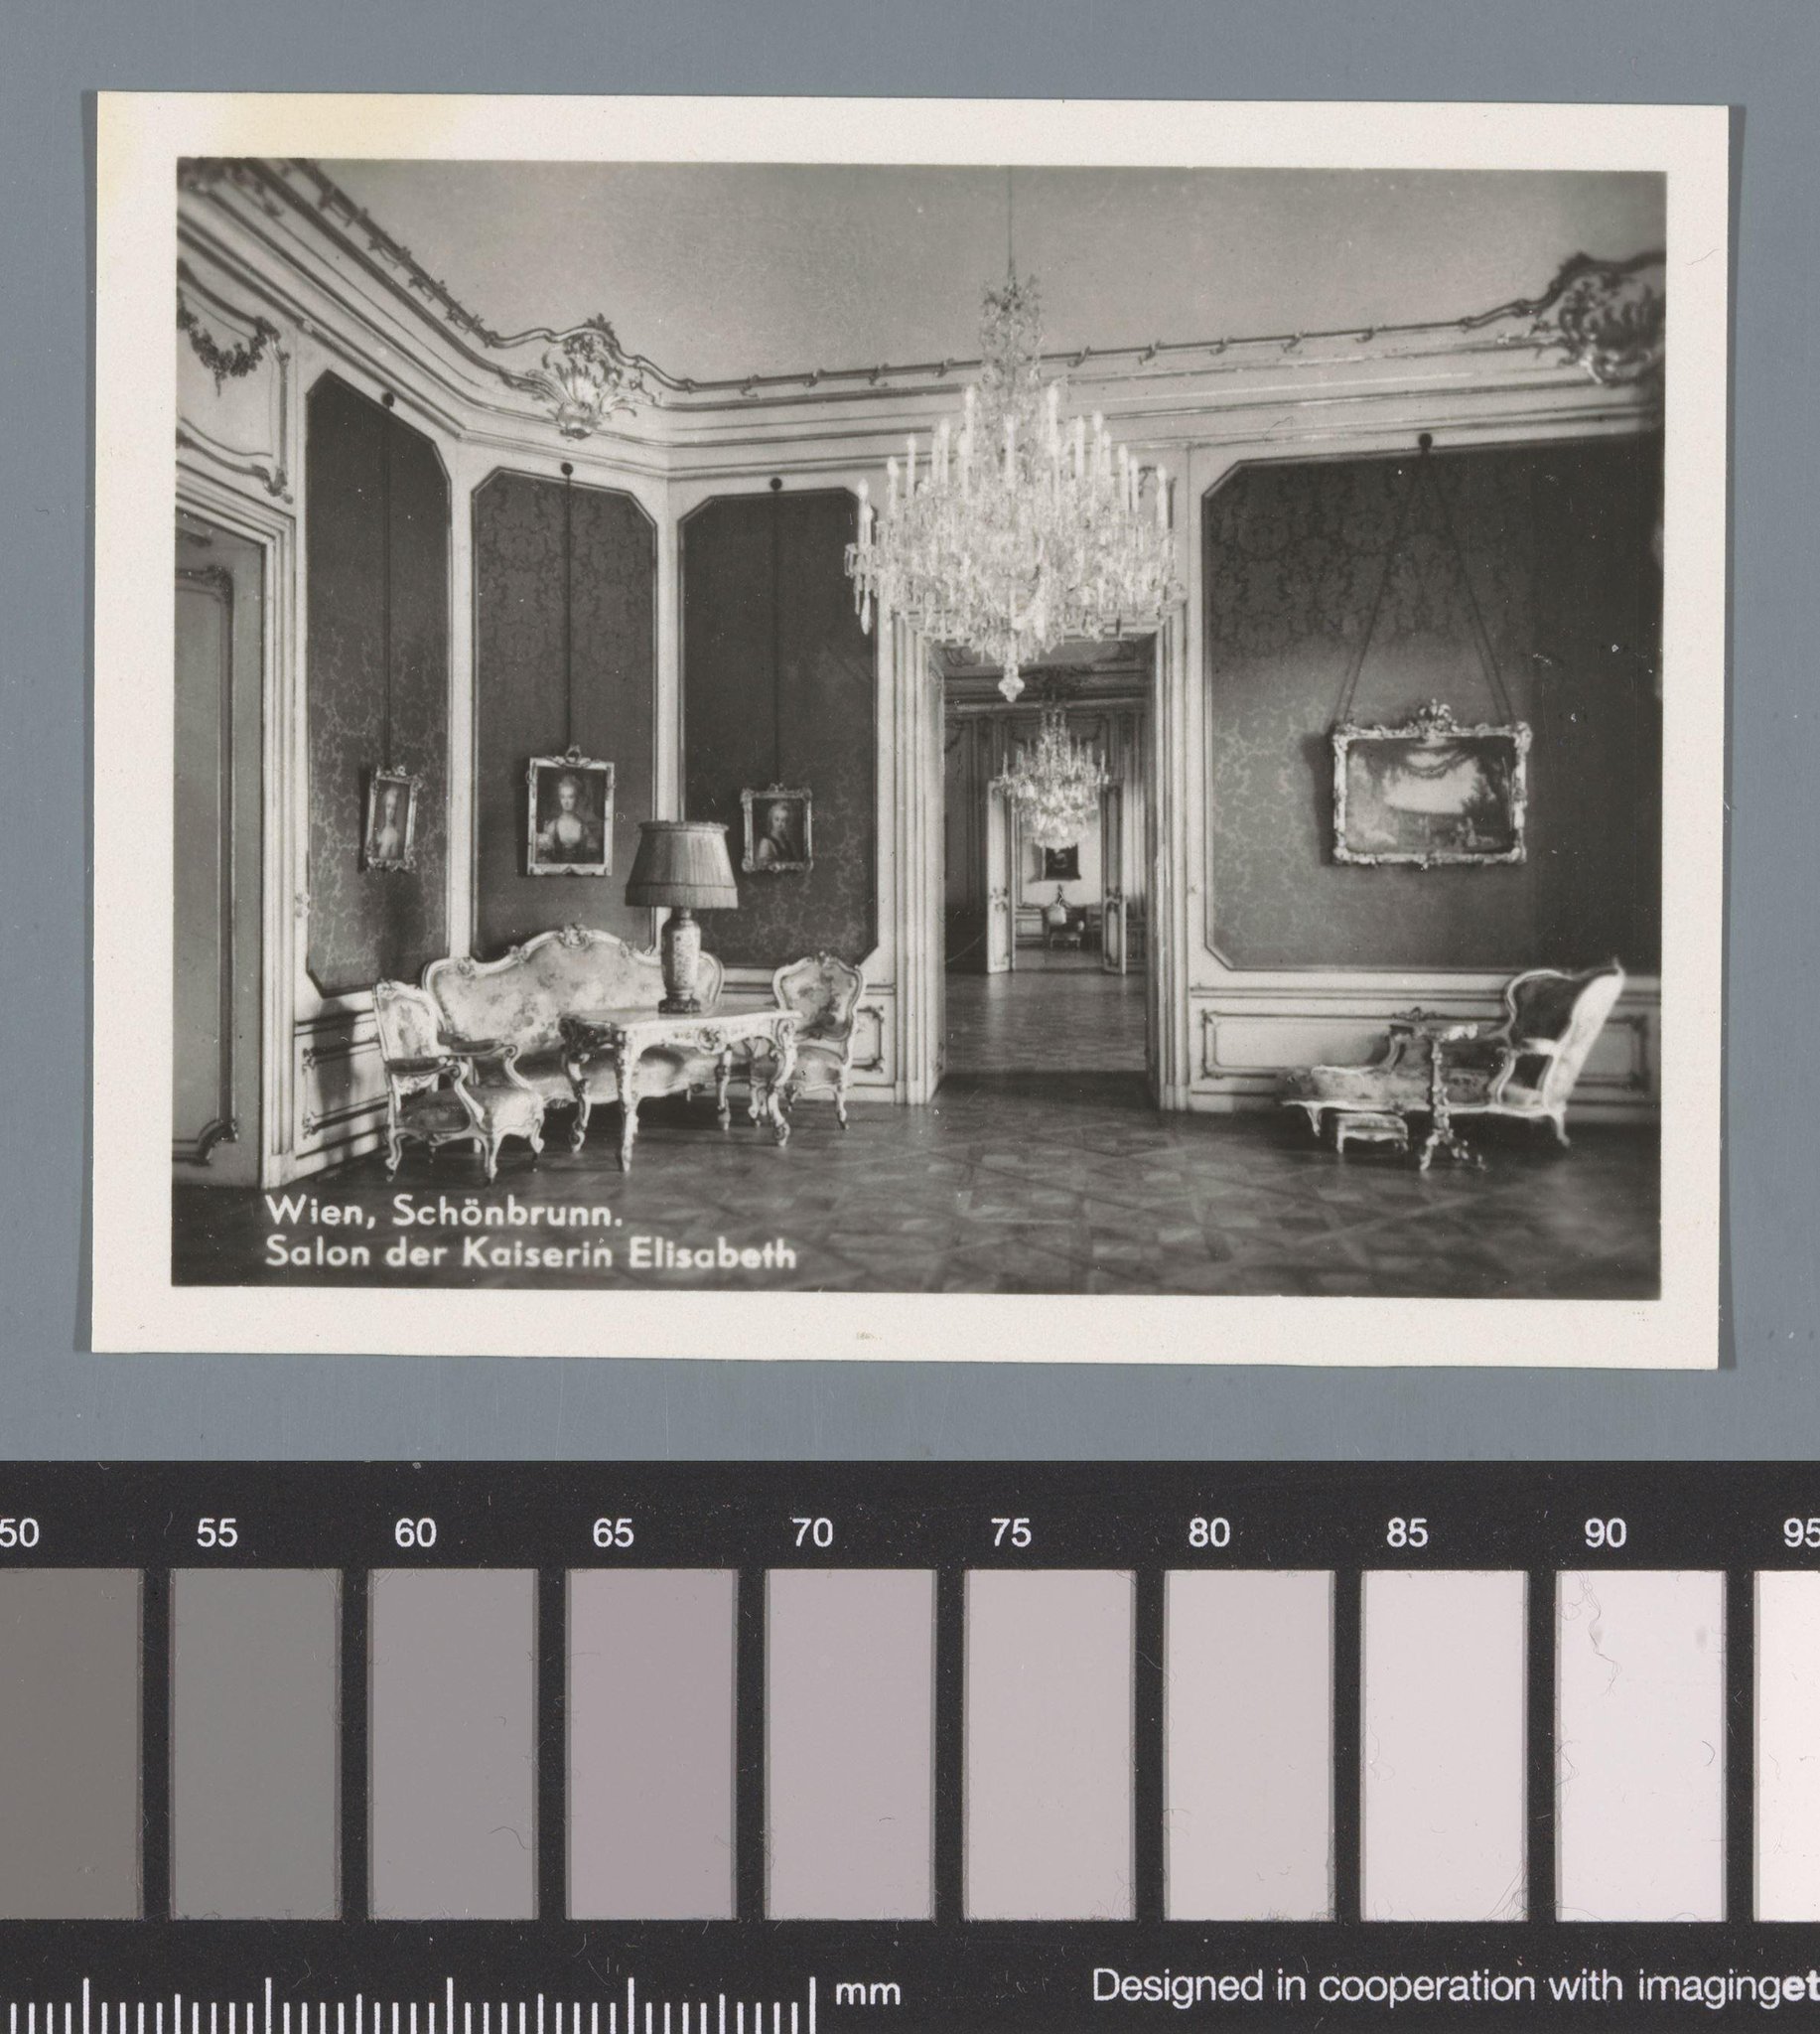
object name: photograph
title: Interieur van de salon van keizerin Elisabeth in Schloss Schönbrunn in Wenen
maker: Anonymous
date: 1950-1960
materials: photographic support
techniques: gelatin silver print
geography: schönbrunn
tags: drawing-room, 'salon'